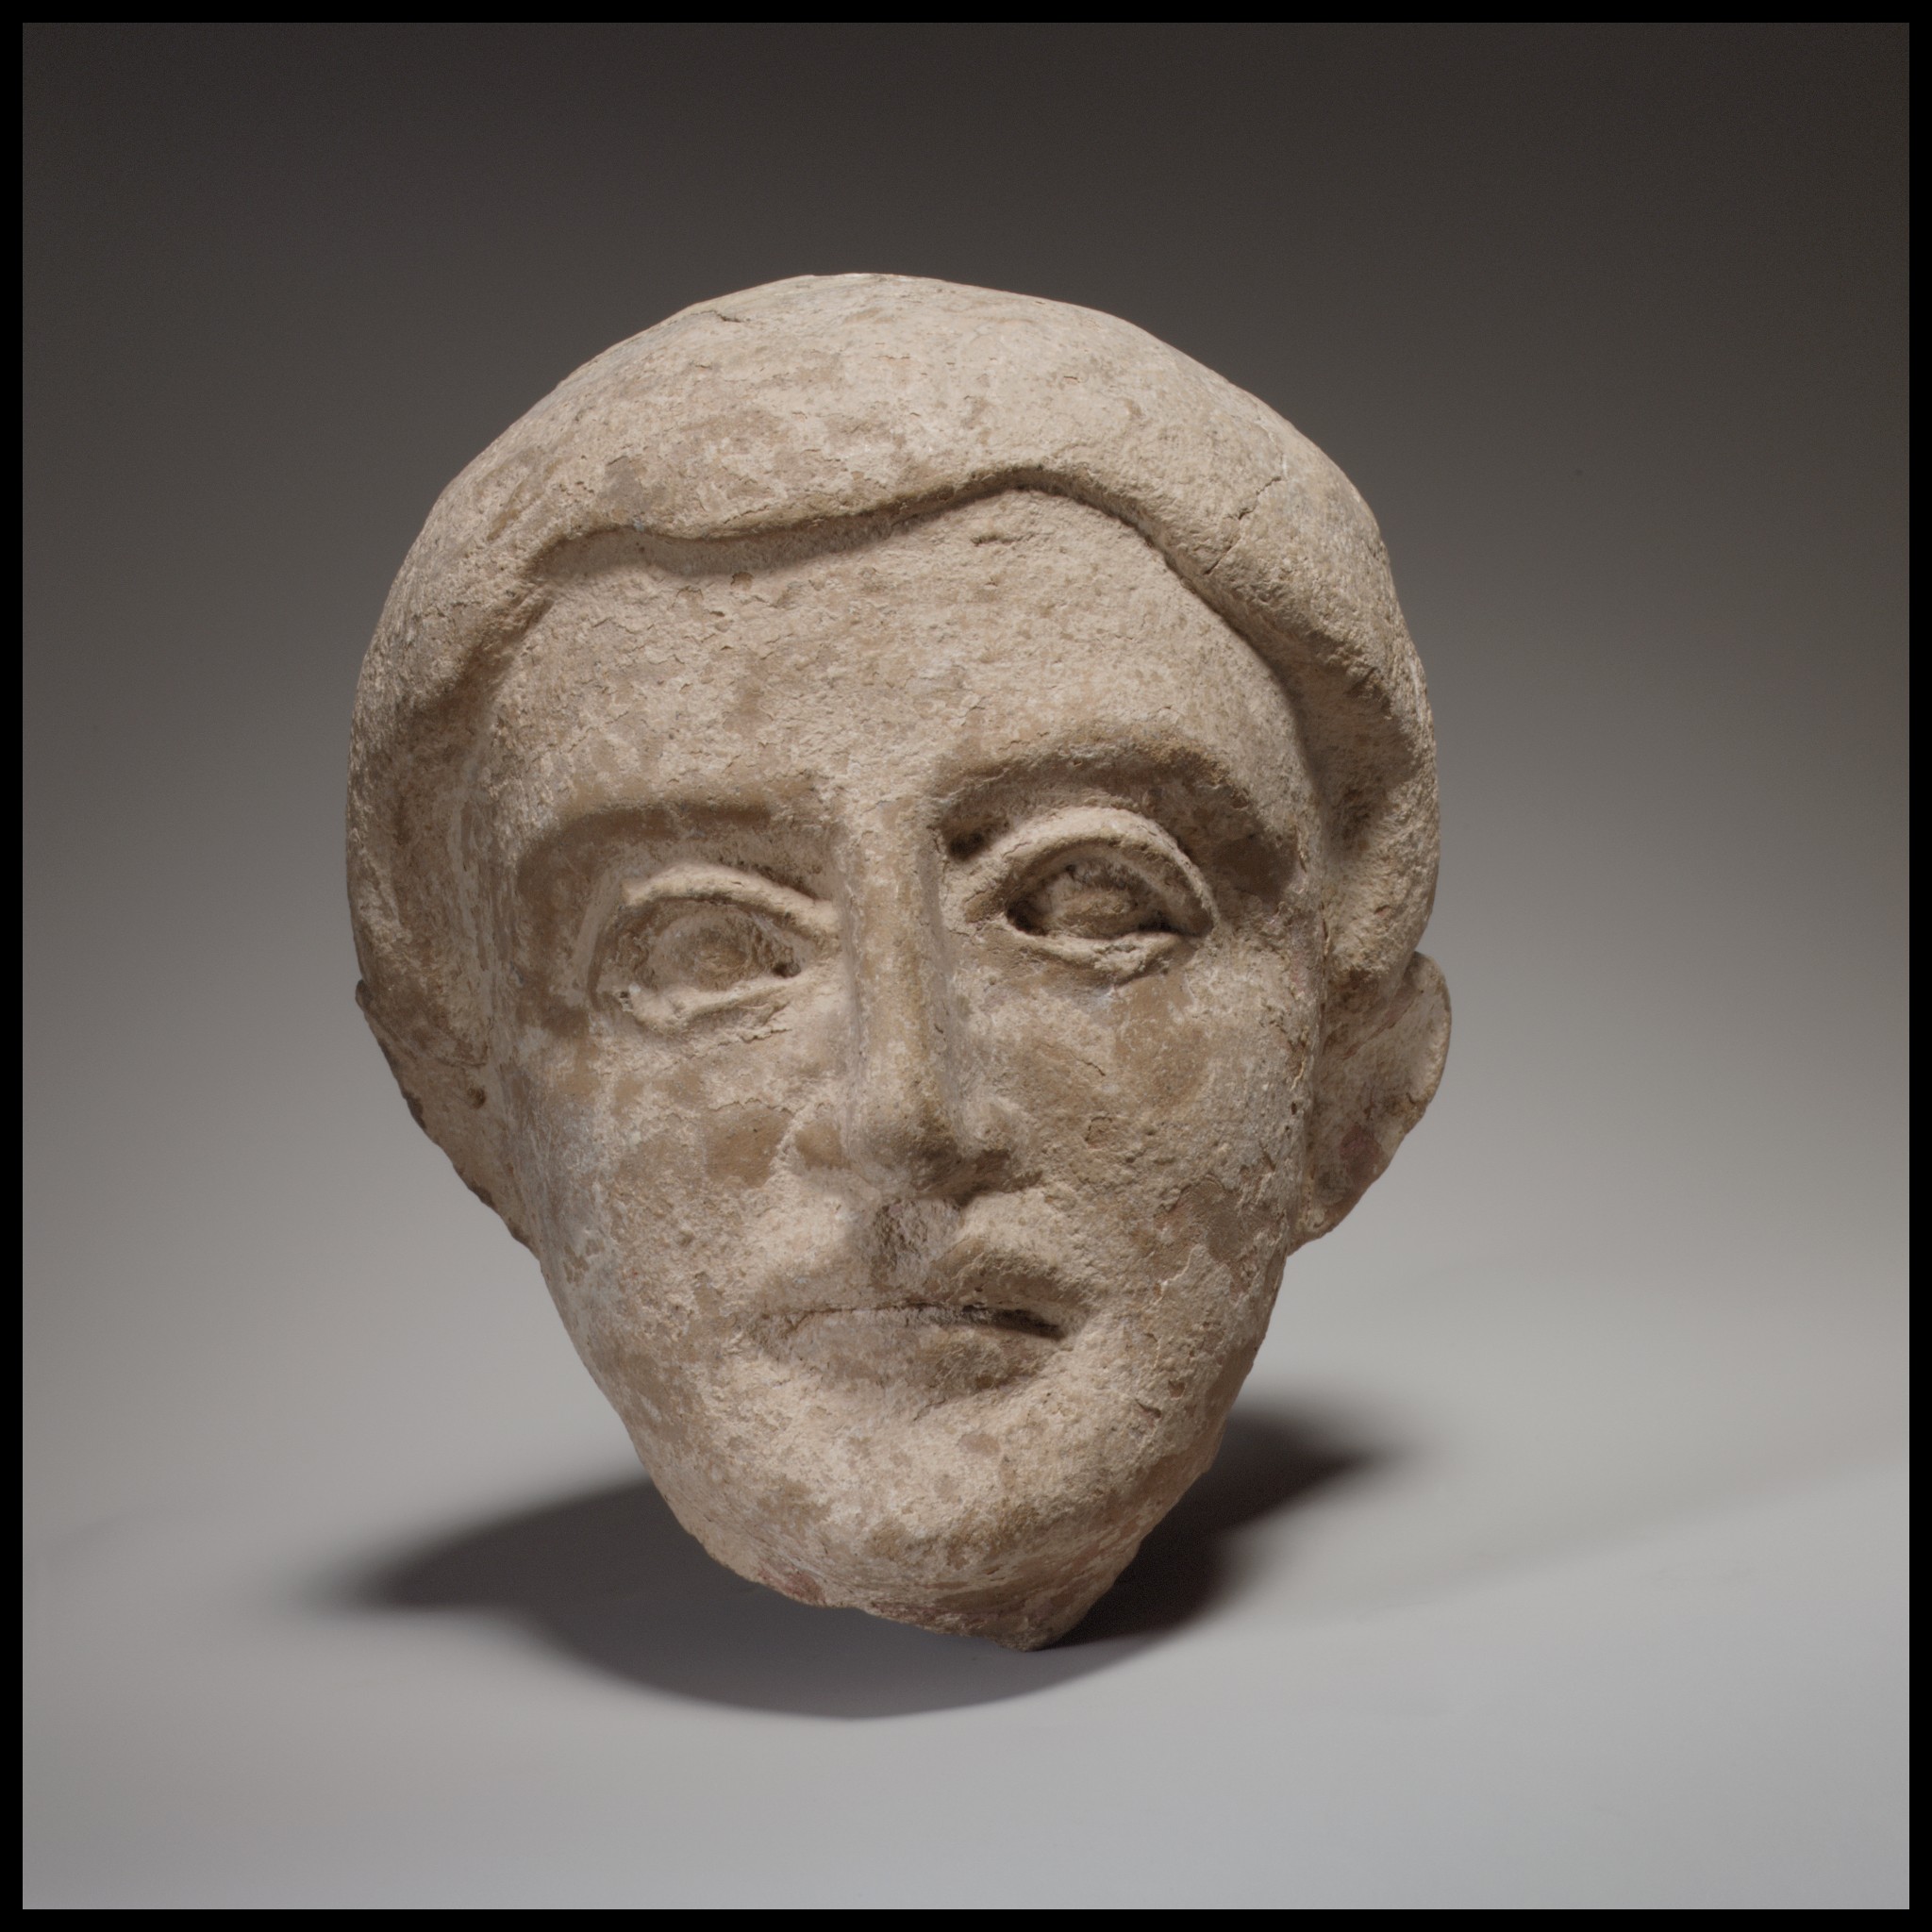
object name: head of a temple boy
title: Terracotta head of a boy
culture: cypriot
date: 300-268 BCE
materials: terracotta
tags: heads,boys